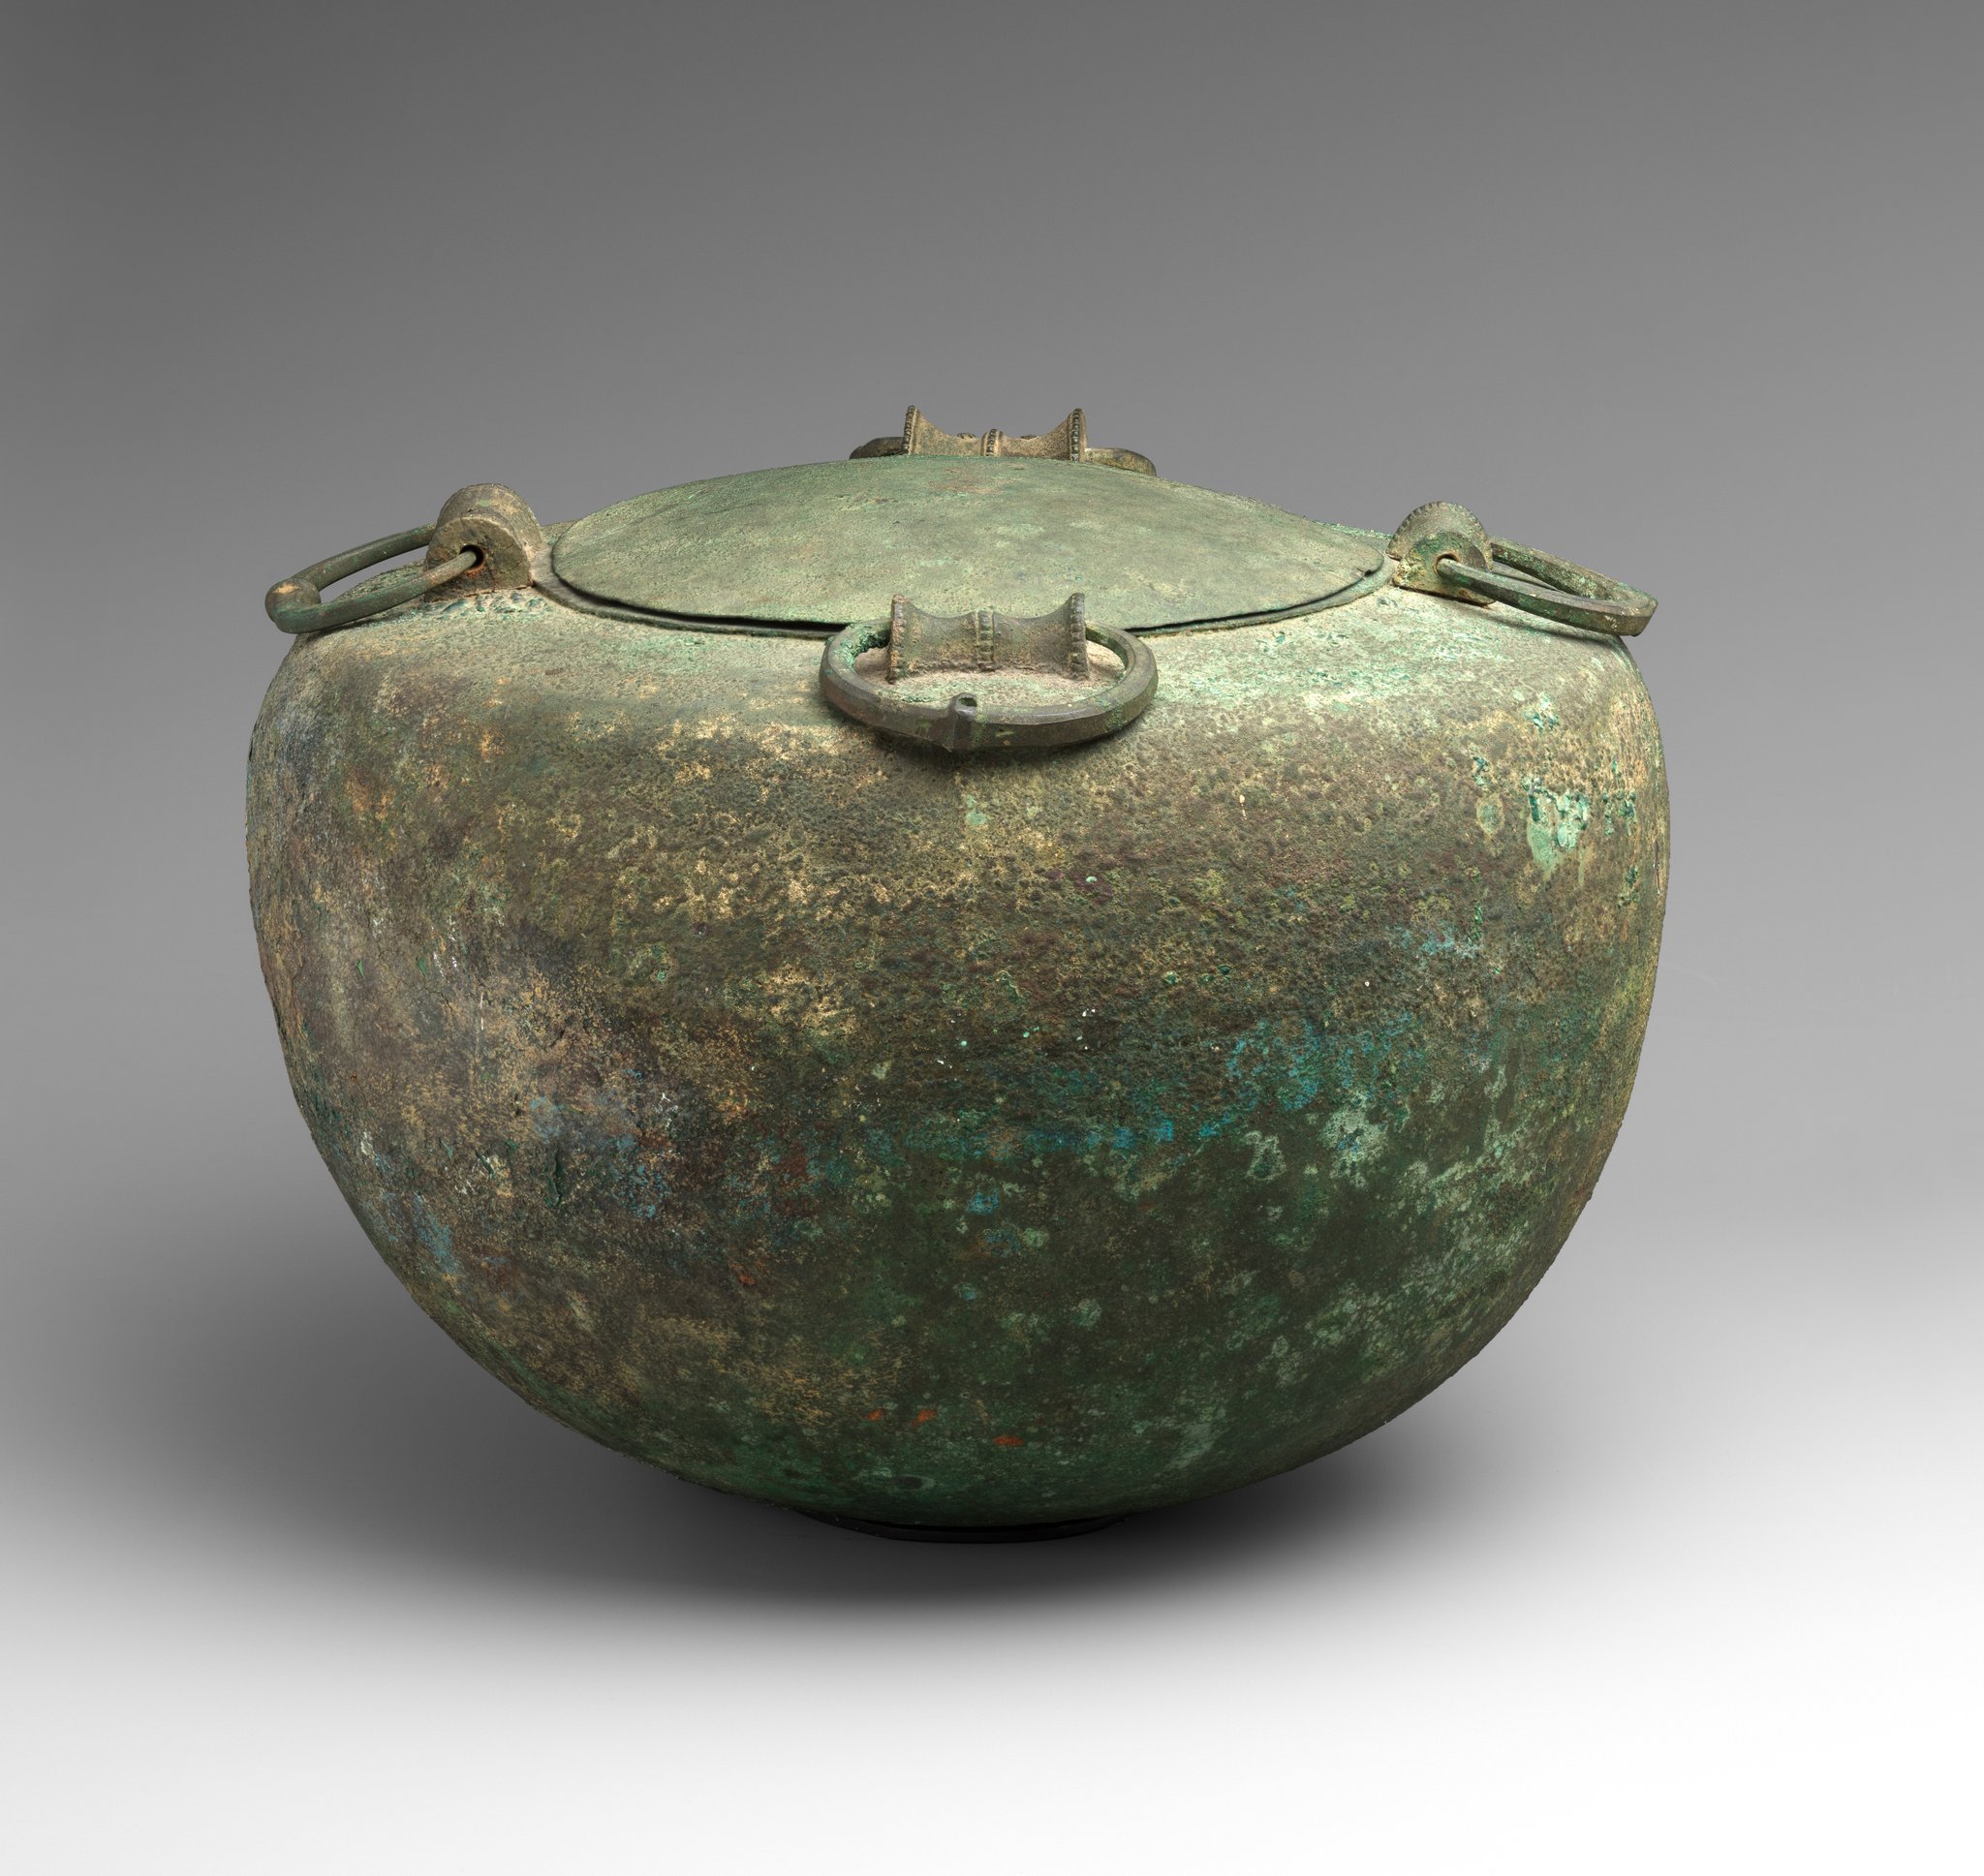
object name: cauldron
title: Cauldron with lid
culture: greek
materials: bronze